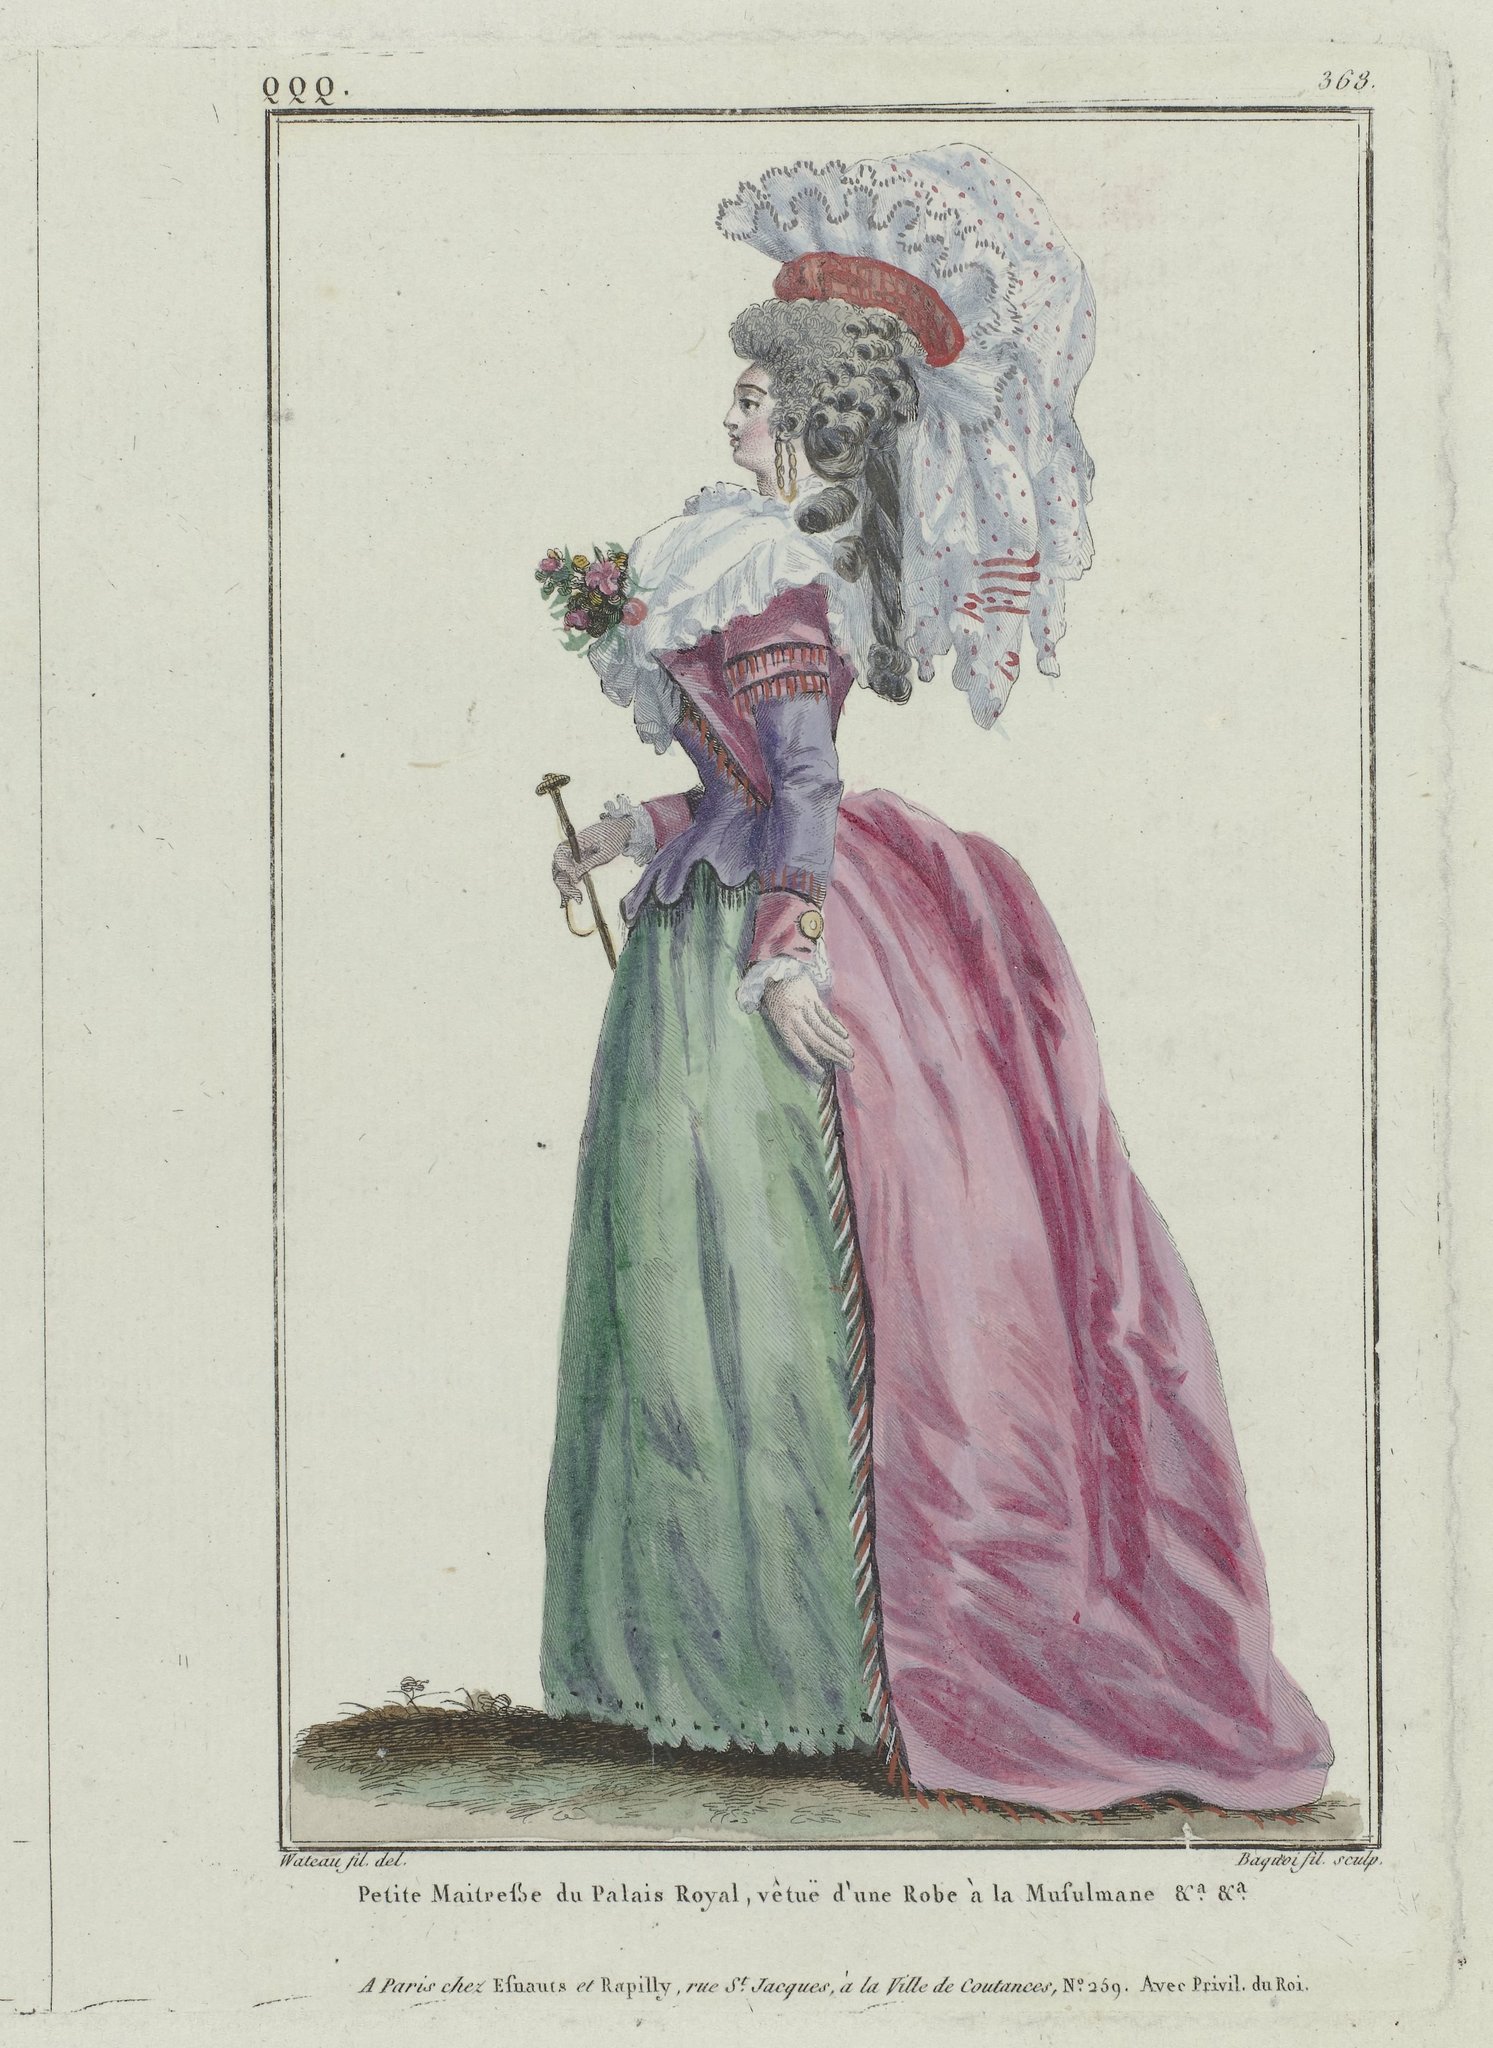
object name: fashion print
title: Gallerie des Modes et Costumes Français, 1787, qqq 368 : Petit Maîtresse du Palais-Royal (...)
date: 1787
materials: paper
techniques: engraving, hand coloring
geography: paris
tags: corsage (+ women's clothes), ear-rings (+ women's clothes), walking-stick, staff, cane (+ women's clothes), head-gear: cap (+ women's clothes), fashion plates, dress, gown (+ women's clothes), piece of clothing covering the breast or décolleté (fichu) (+ women's clothes), fashionable woman, 'belle'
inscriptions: caption: ‘Petit Maitresse du Palais-Royal, vêtuë d'une Robe à la Musulmane &.a &.a.’, address: ‘A Paris chez Esnauts et Rapilly, rue S.t Jacques, à la Ville de Coutances, No. 259. Avec Privil. du Roi.’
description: Petite Maitresse bij het Palais Royal, gekleed in een japon of 'robe à la Musulmane'. Fichu. Accessories: muts, oorbel, bloemcorsage, wandelstok. Uit de serie qqq. 69e (pour 59) cahier de costumes français, habillemens à la mode, Gallerie des Modes et Costumes Français. Twee afbeeldingen op één plaat gedrukt, zie ook qqq. 367.